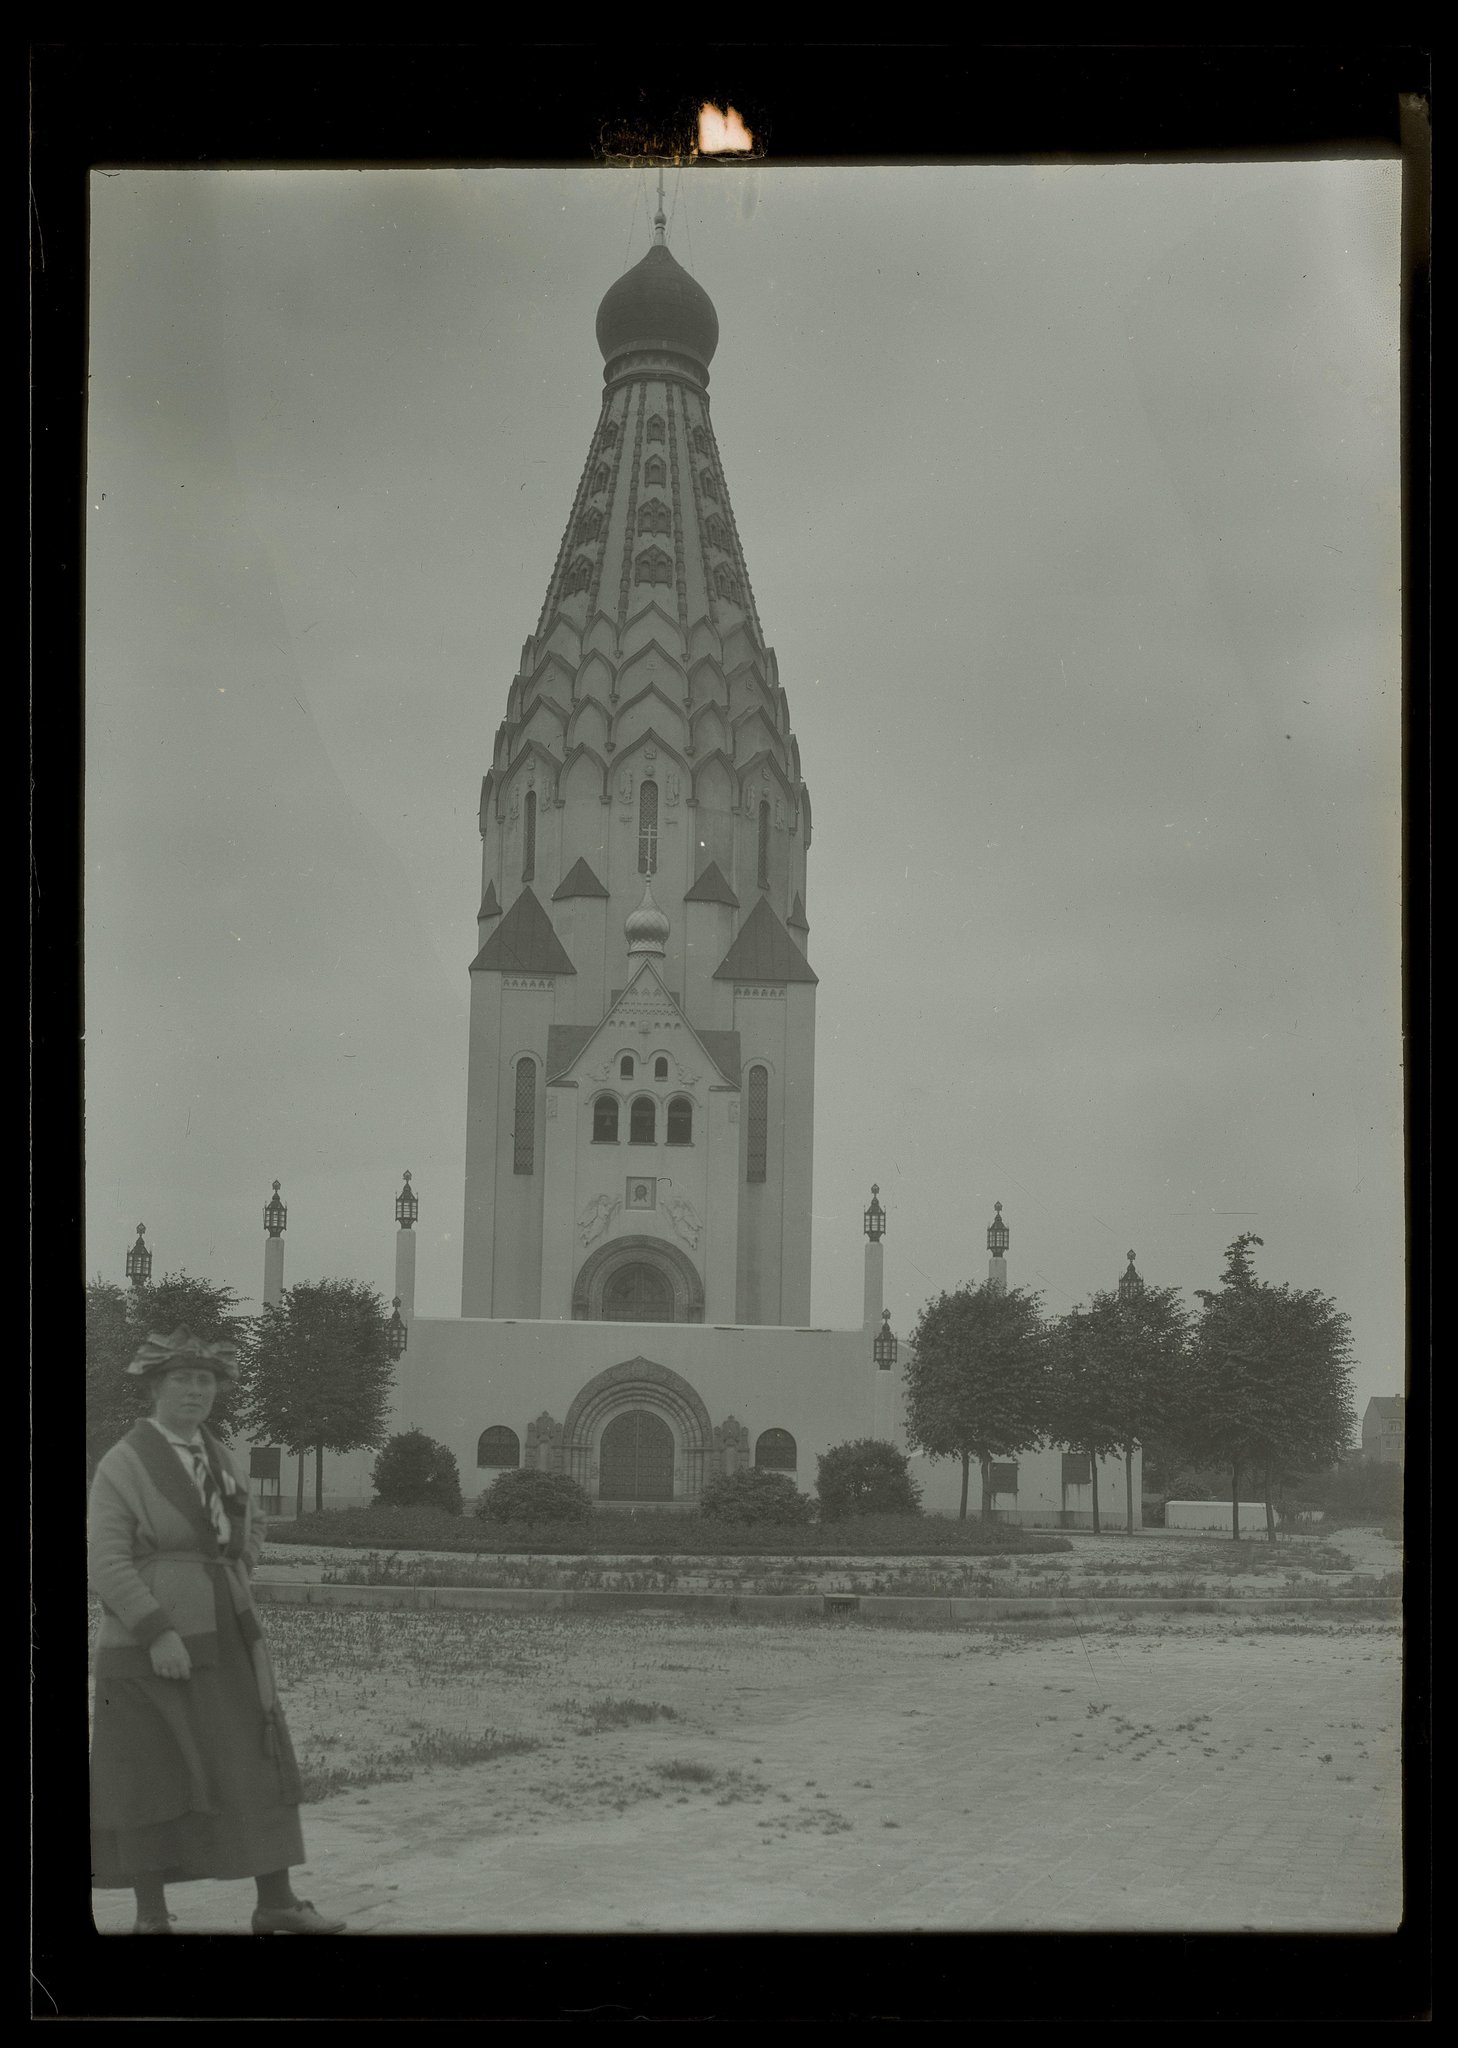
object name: photograph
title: Filmnegatief met opname van Leipzig en huis te Bünde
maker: Anonymous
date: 1921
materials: film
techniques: gelatin silver negative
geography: germany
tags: germany